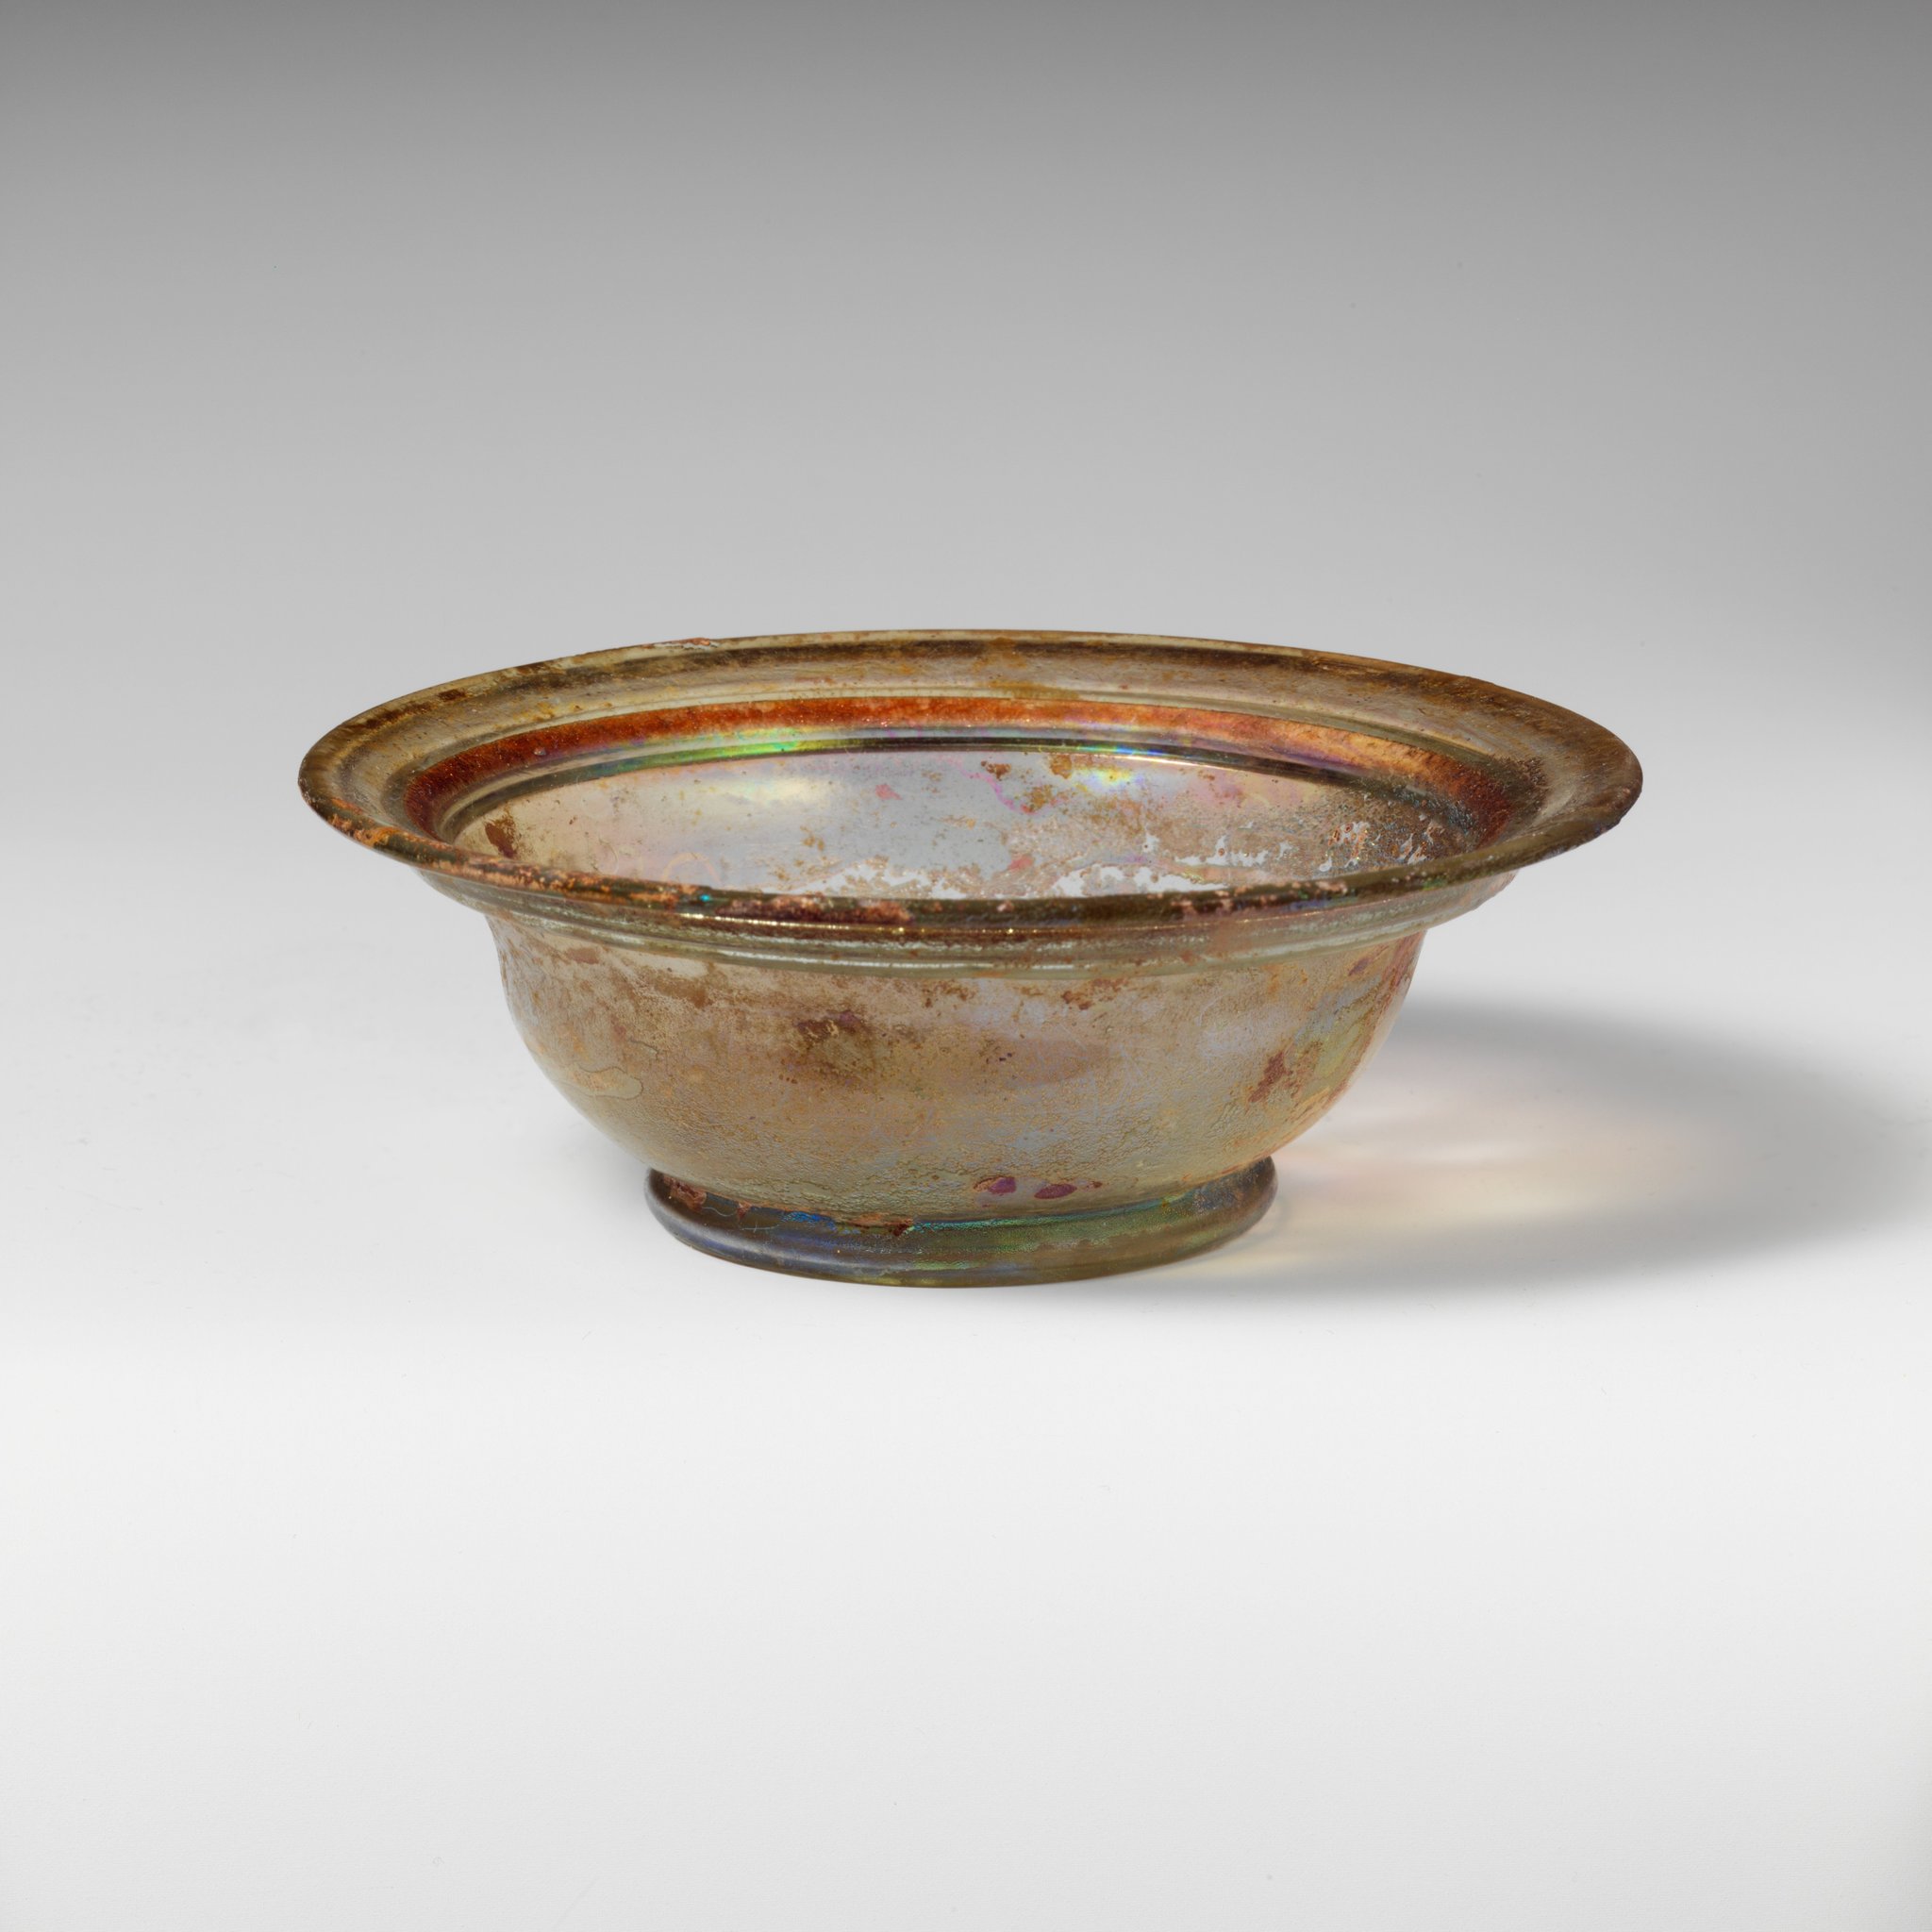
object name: bowl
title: Glass bowl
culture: roman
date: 101-300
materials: glass